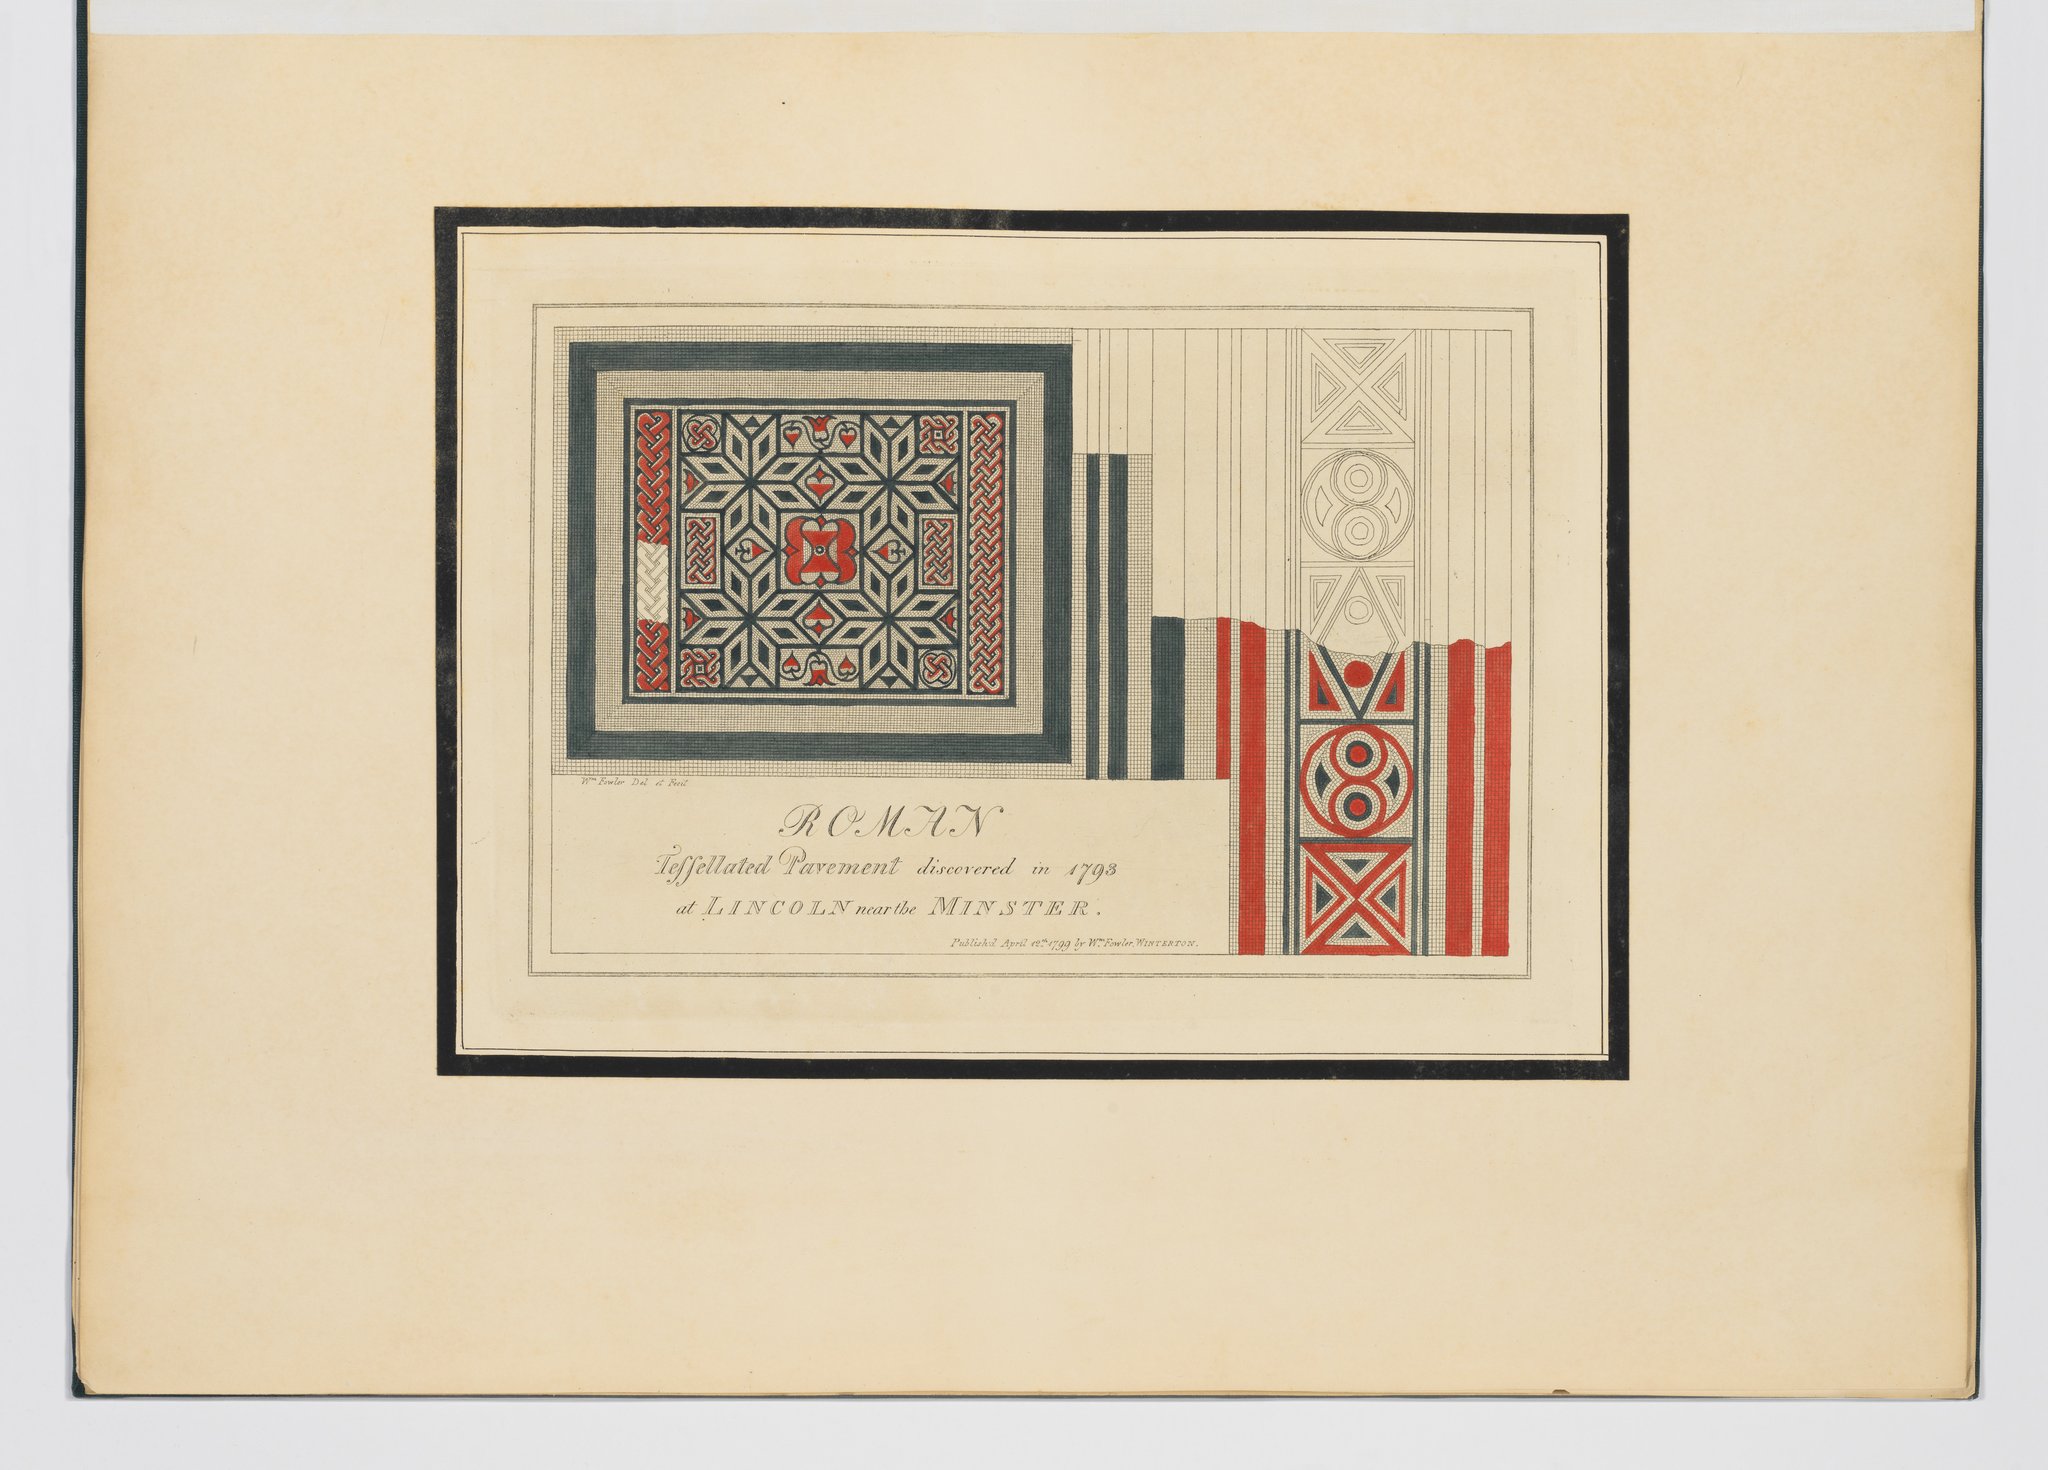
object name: album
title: Engravings of the Principal Mosaic Pavements...in Various Parts of Great Britain, also...of Several Subjects in Stained Glass, Volume 1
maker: william fowler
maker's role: artist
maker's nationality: british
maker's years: 1761-1832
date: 1804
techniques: aquatint, engraving, etching